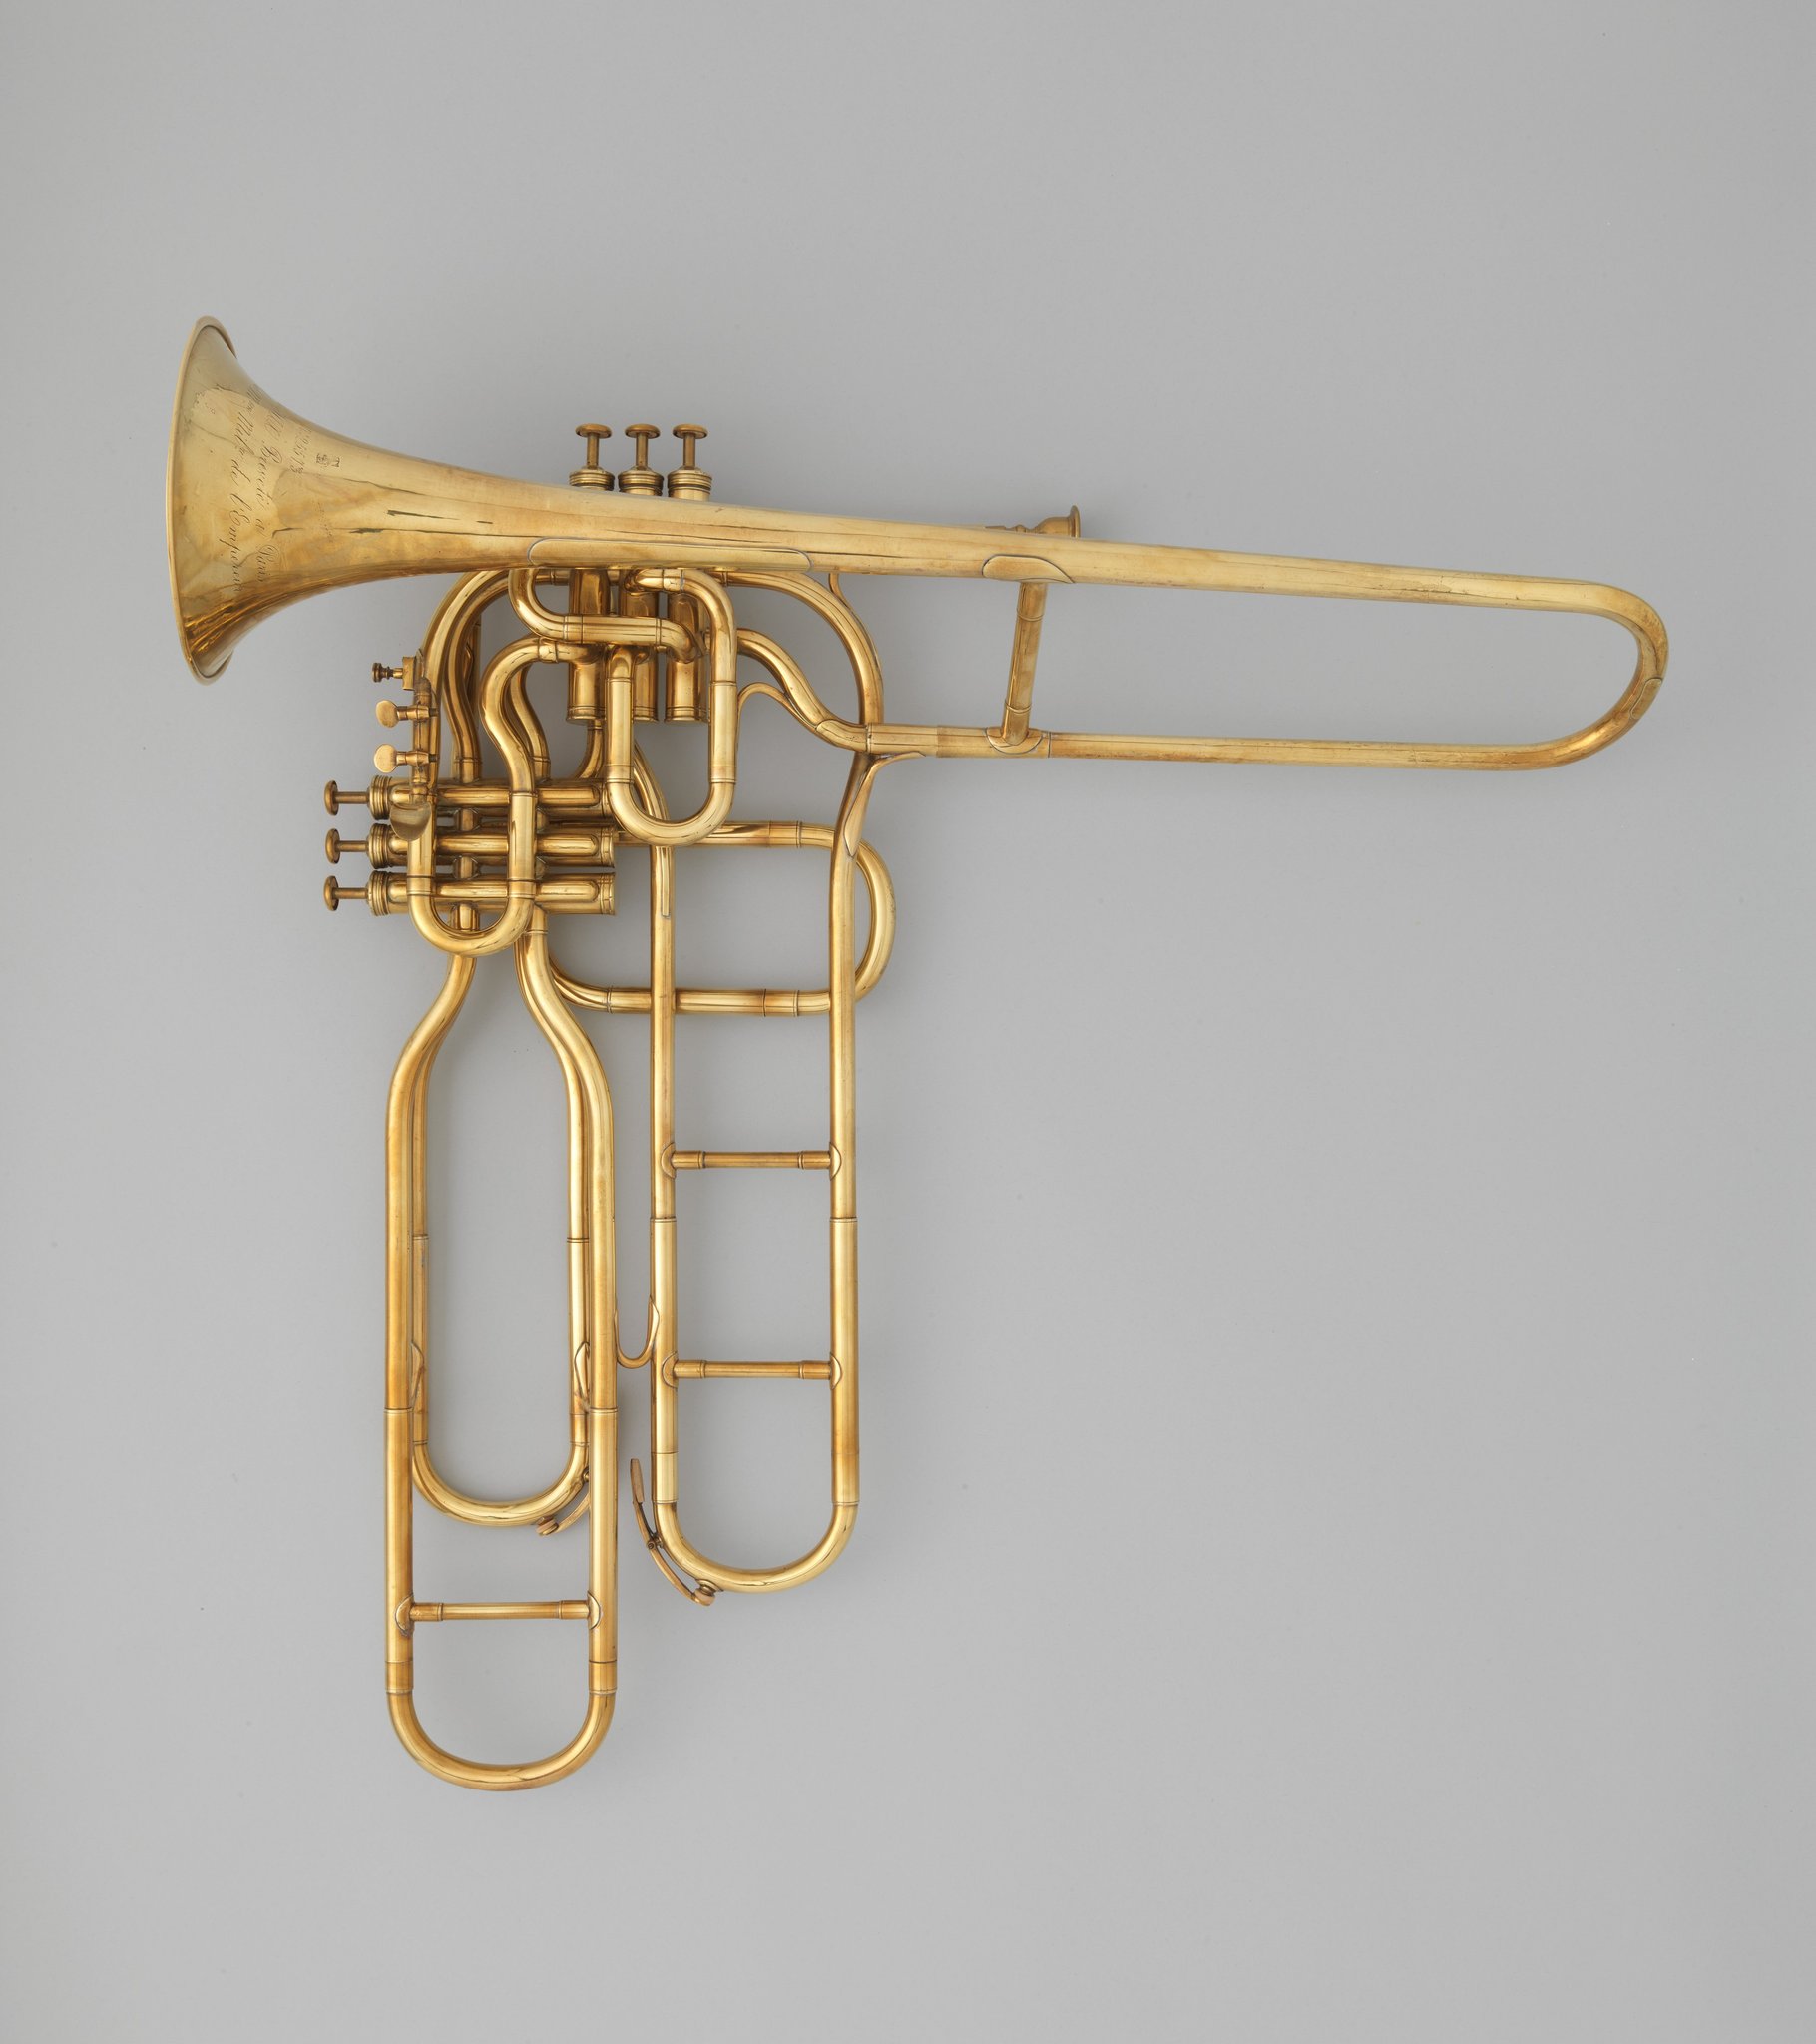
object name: tenor valve trombone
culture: french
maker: adolphe (antoine joseph) sax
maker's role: maker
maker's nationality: belgian, active france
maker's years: 1814-1894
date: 1863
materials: brass, cork, metal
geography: france